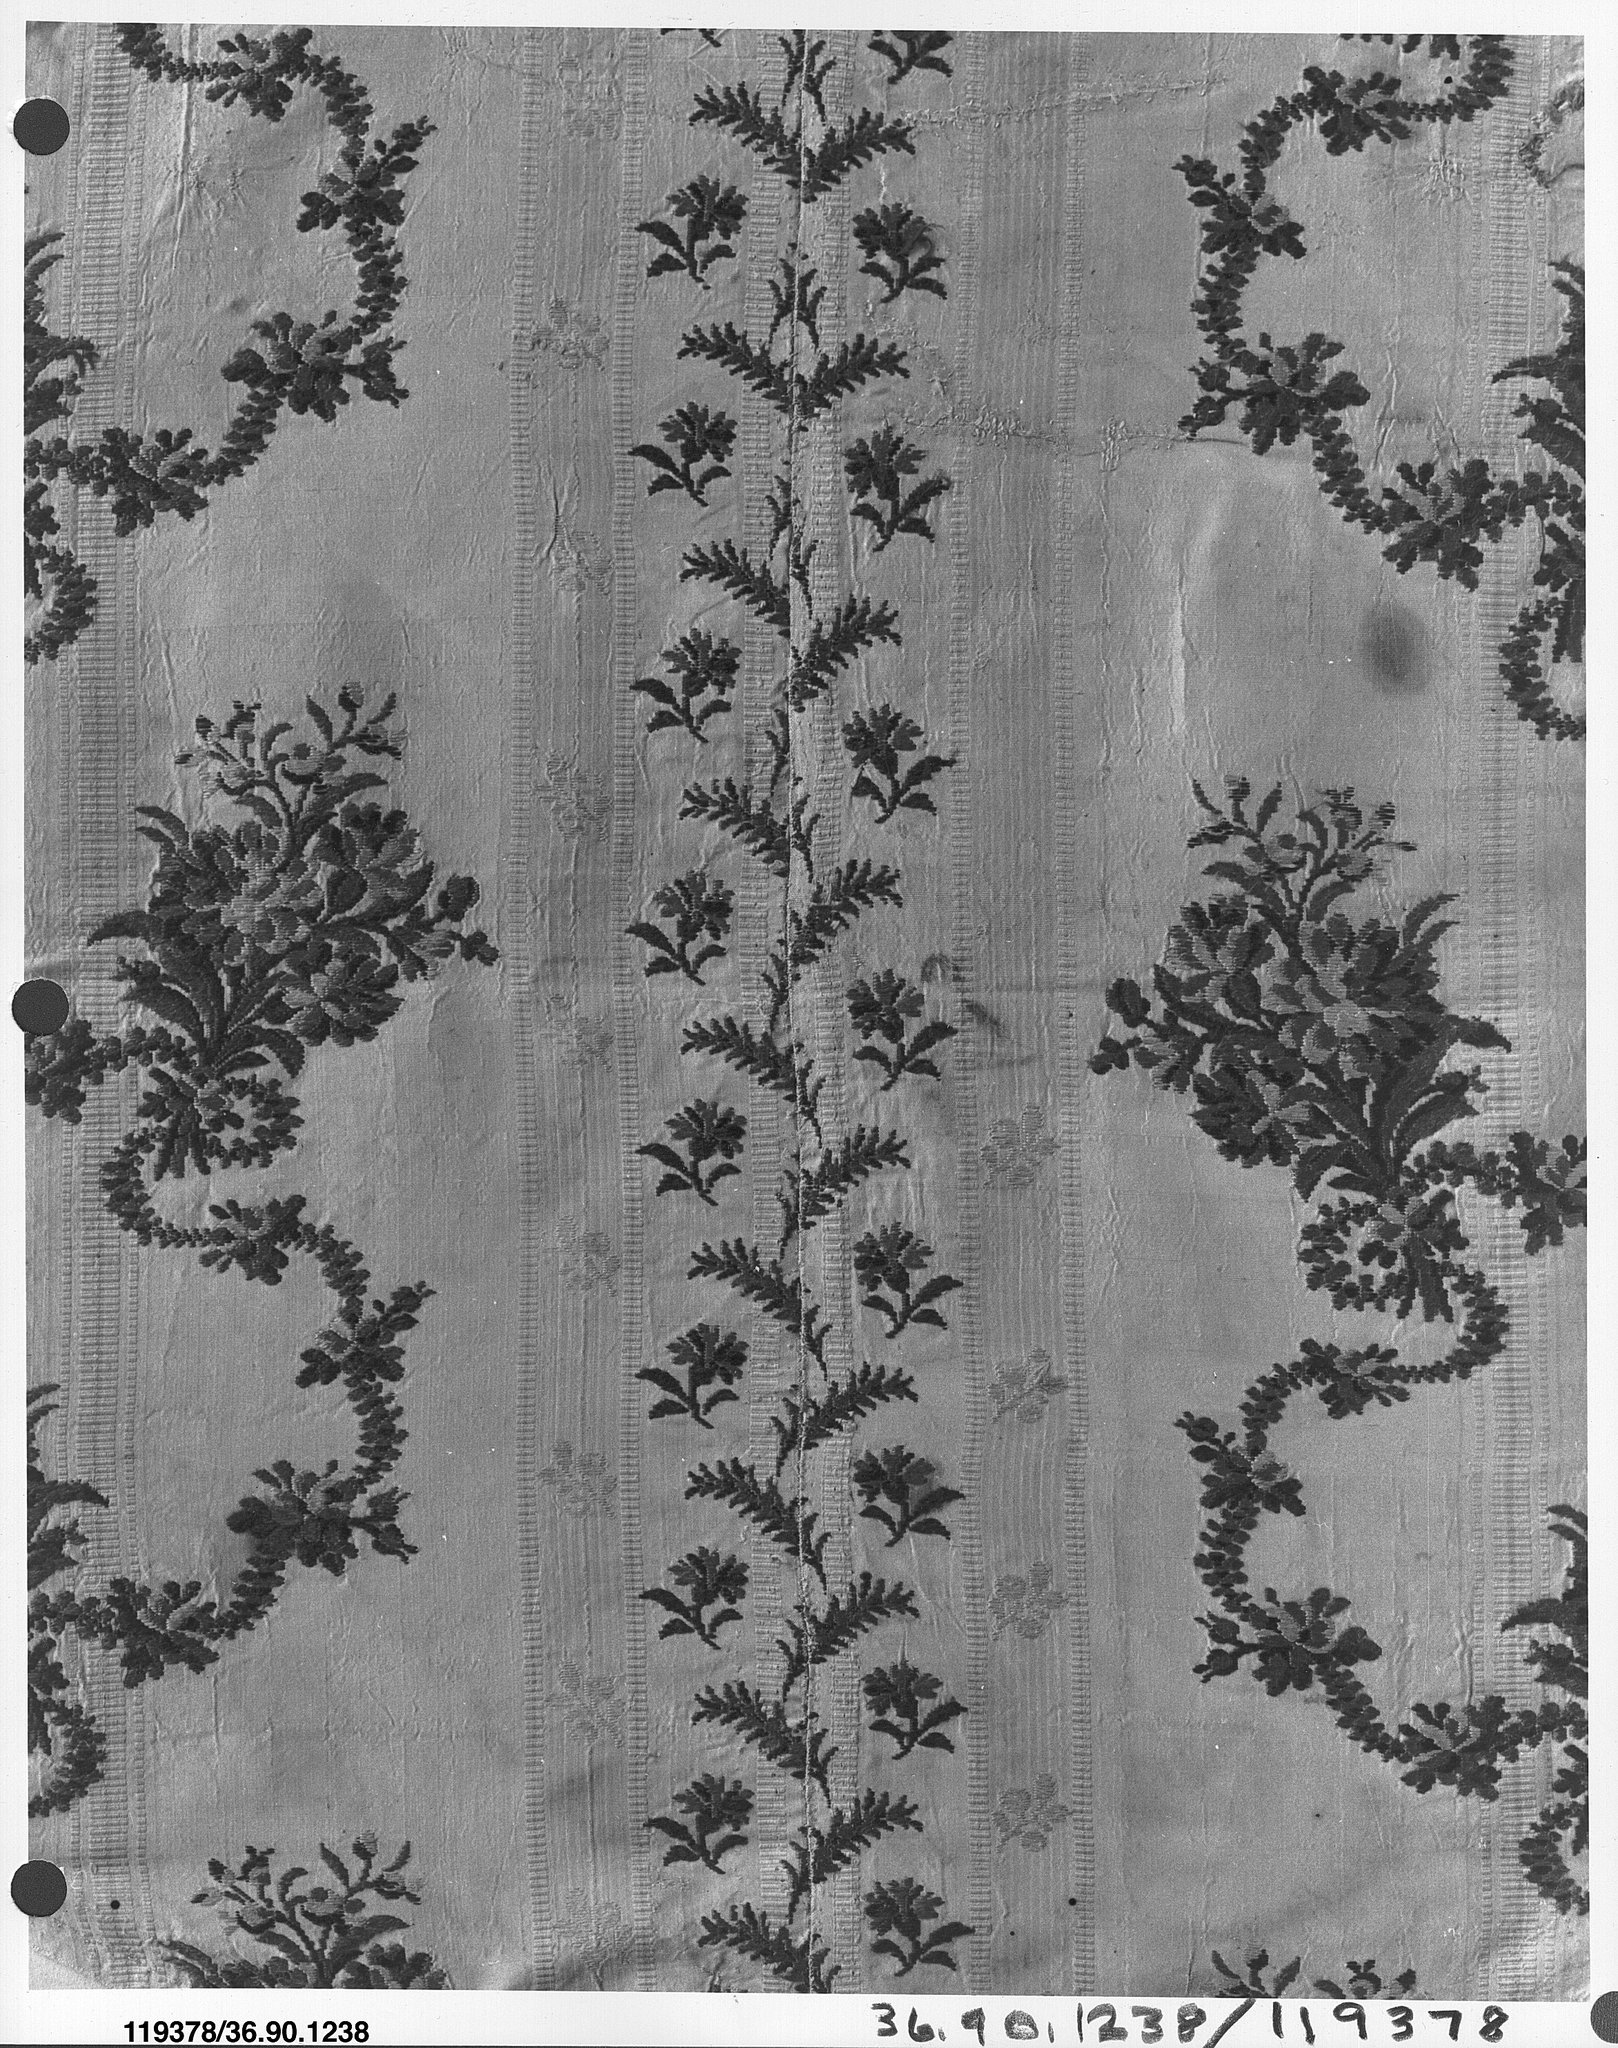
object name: piece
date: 1770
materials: silk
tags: flowers,leaves